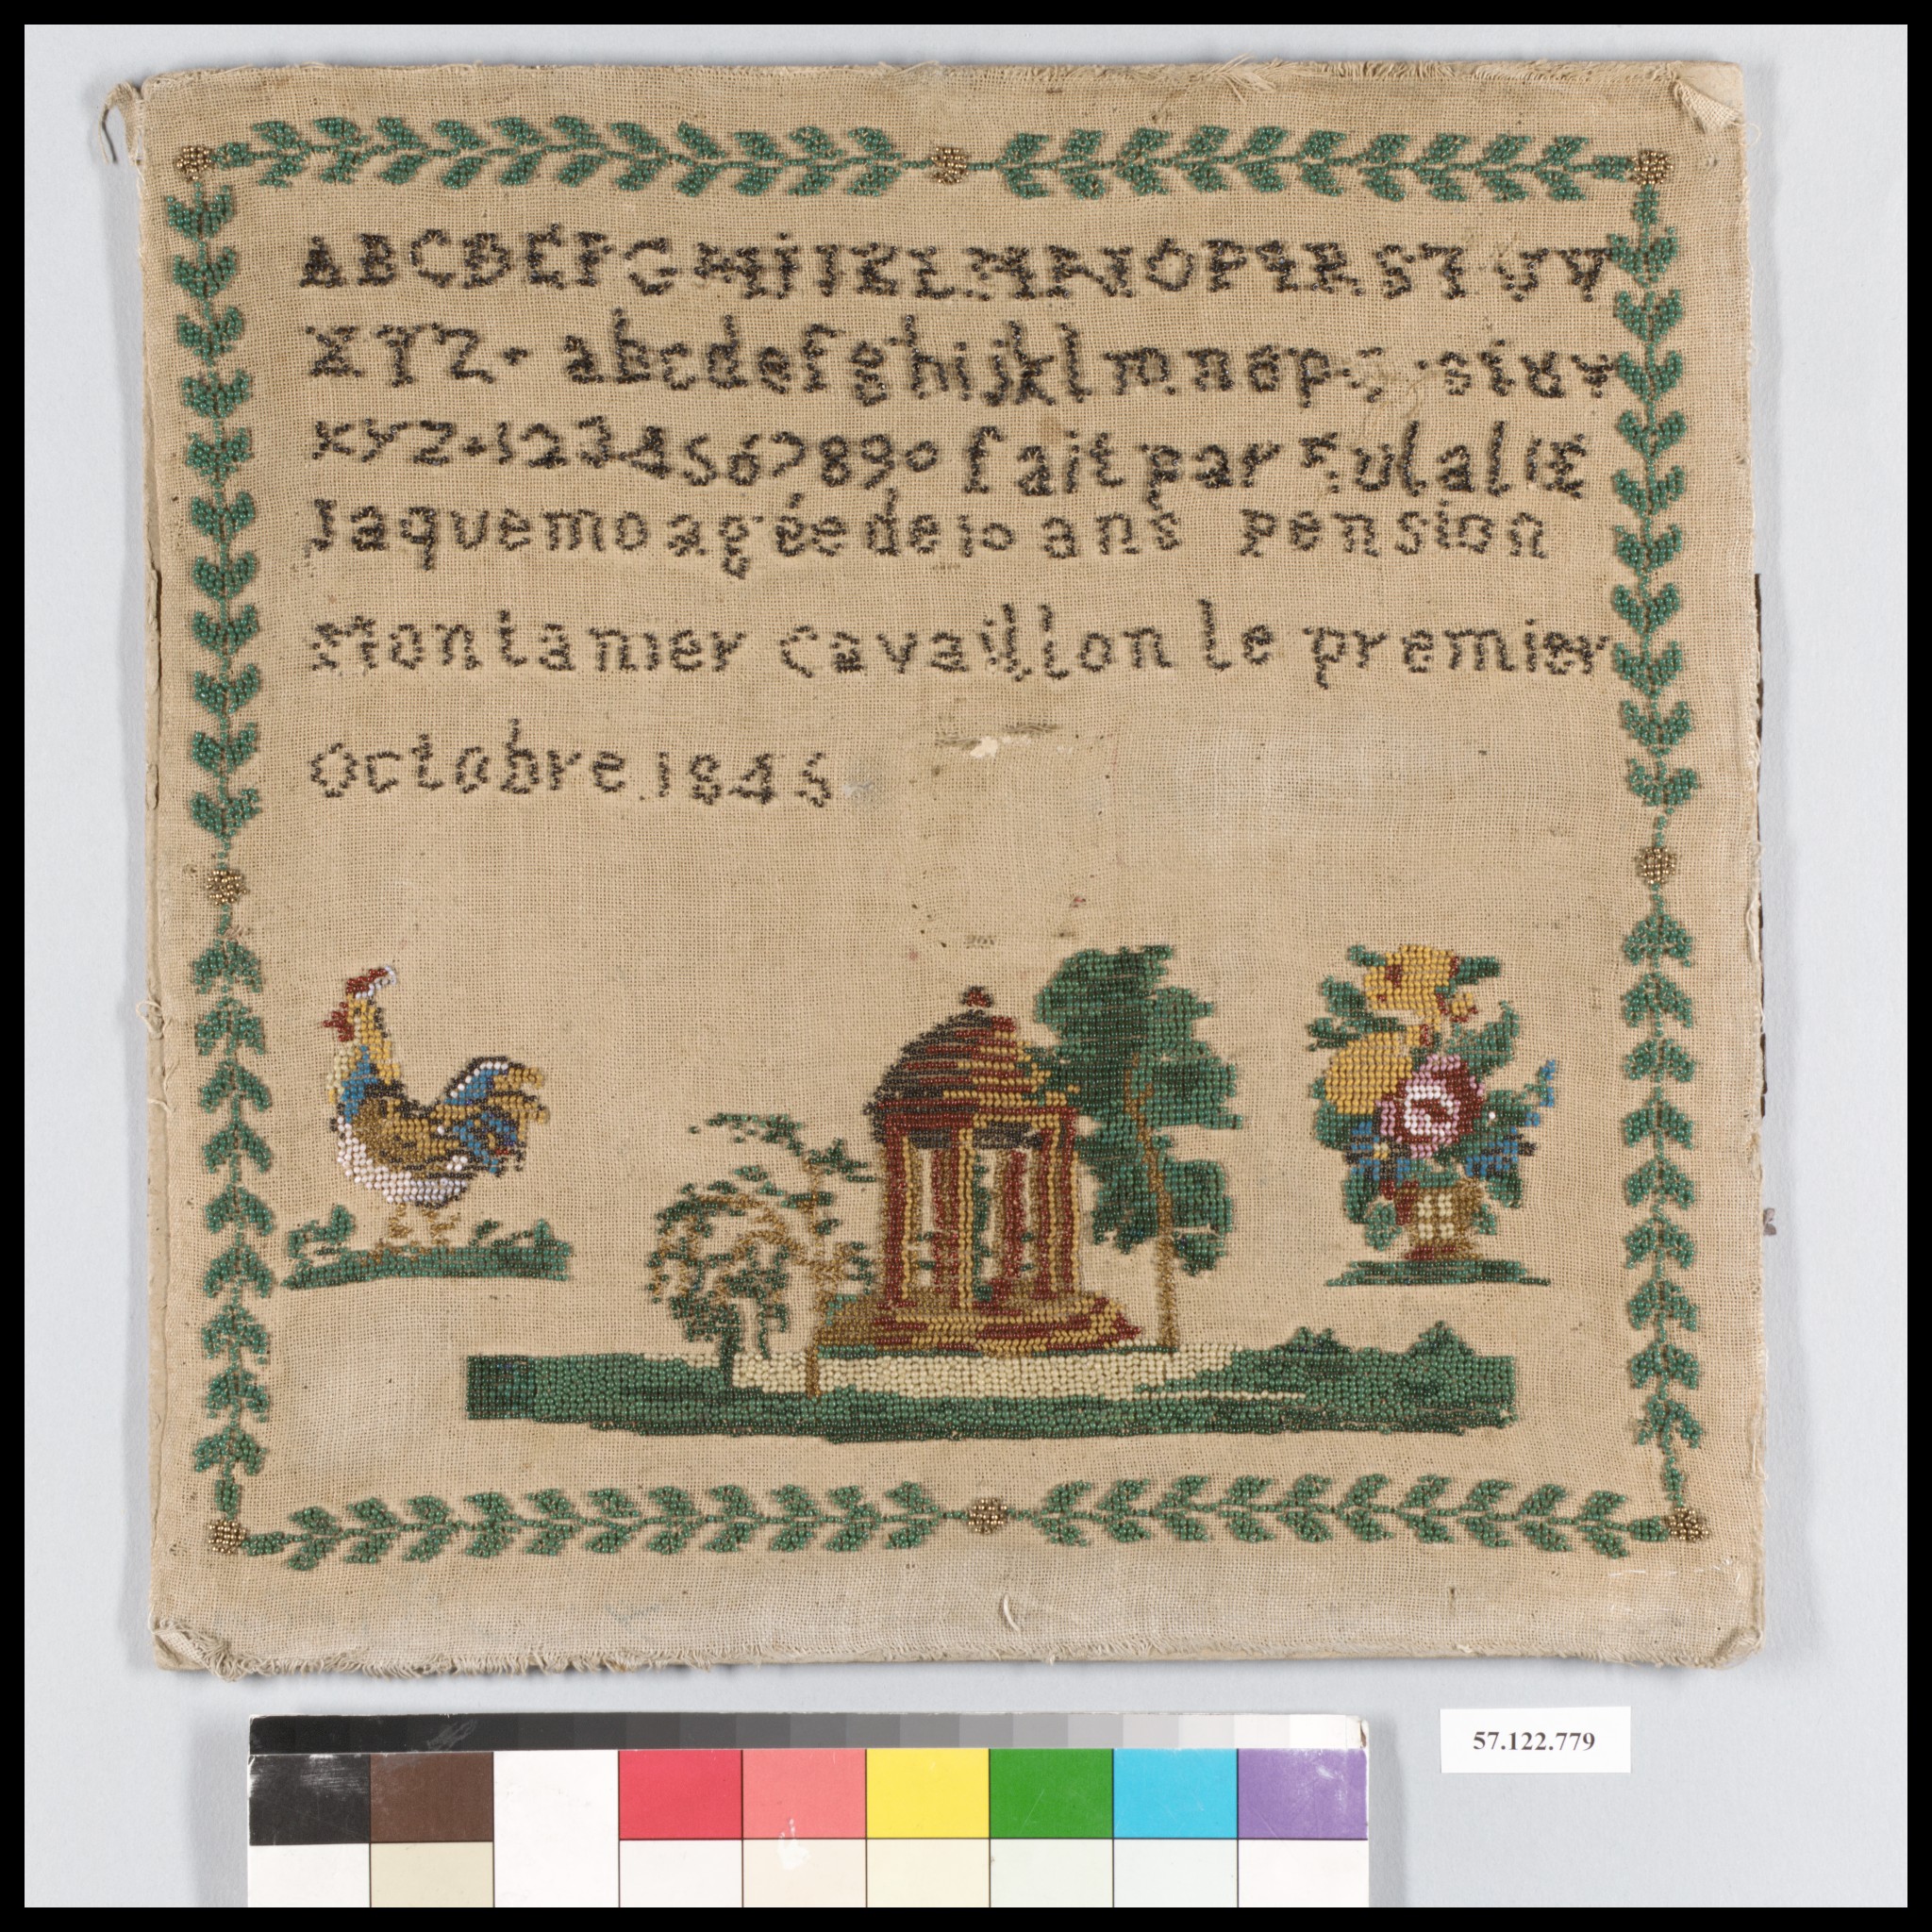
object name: sampler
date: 1845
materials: cotton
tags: roosters,trees